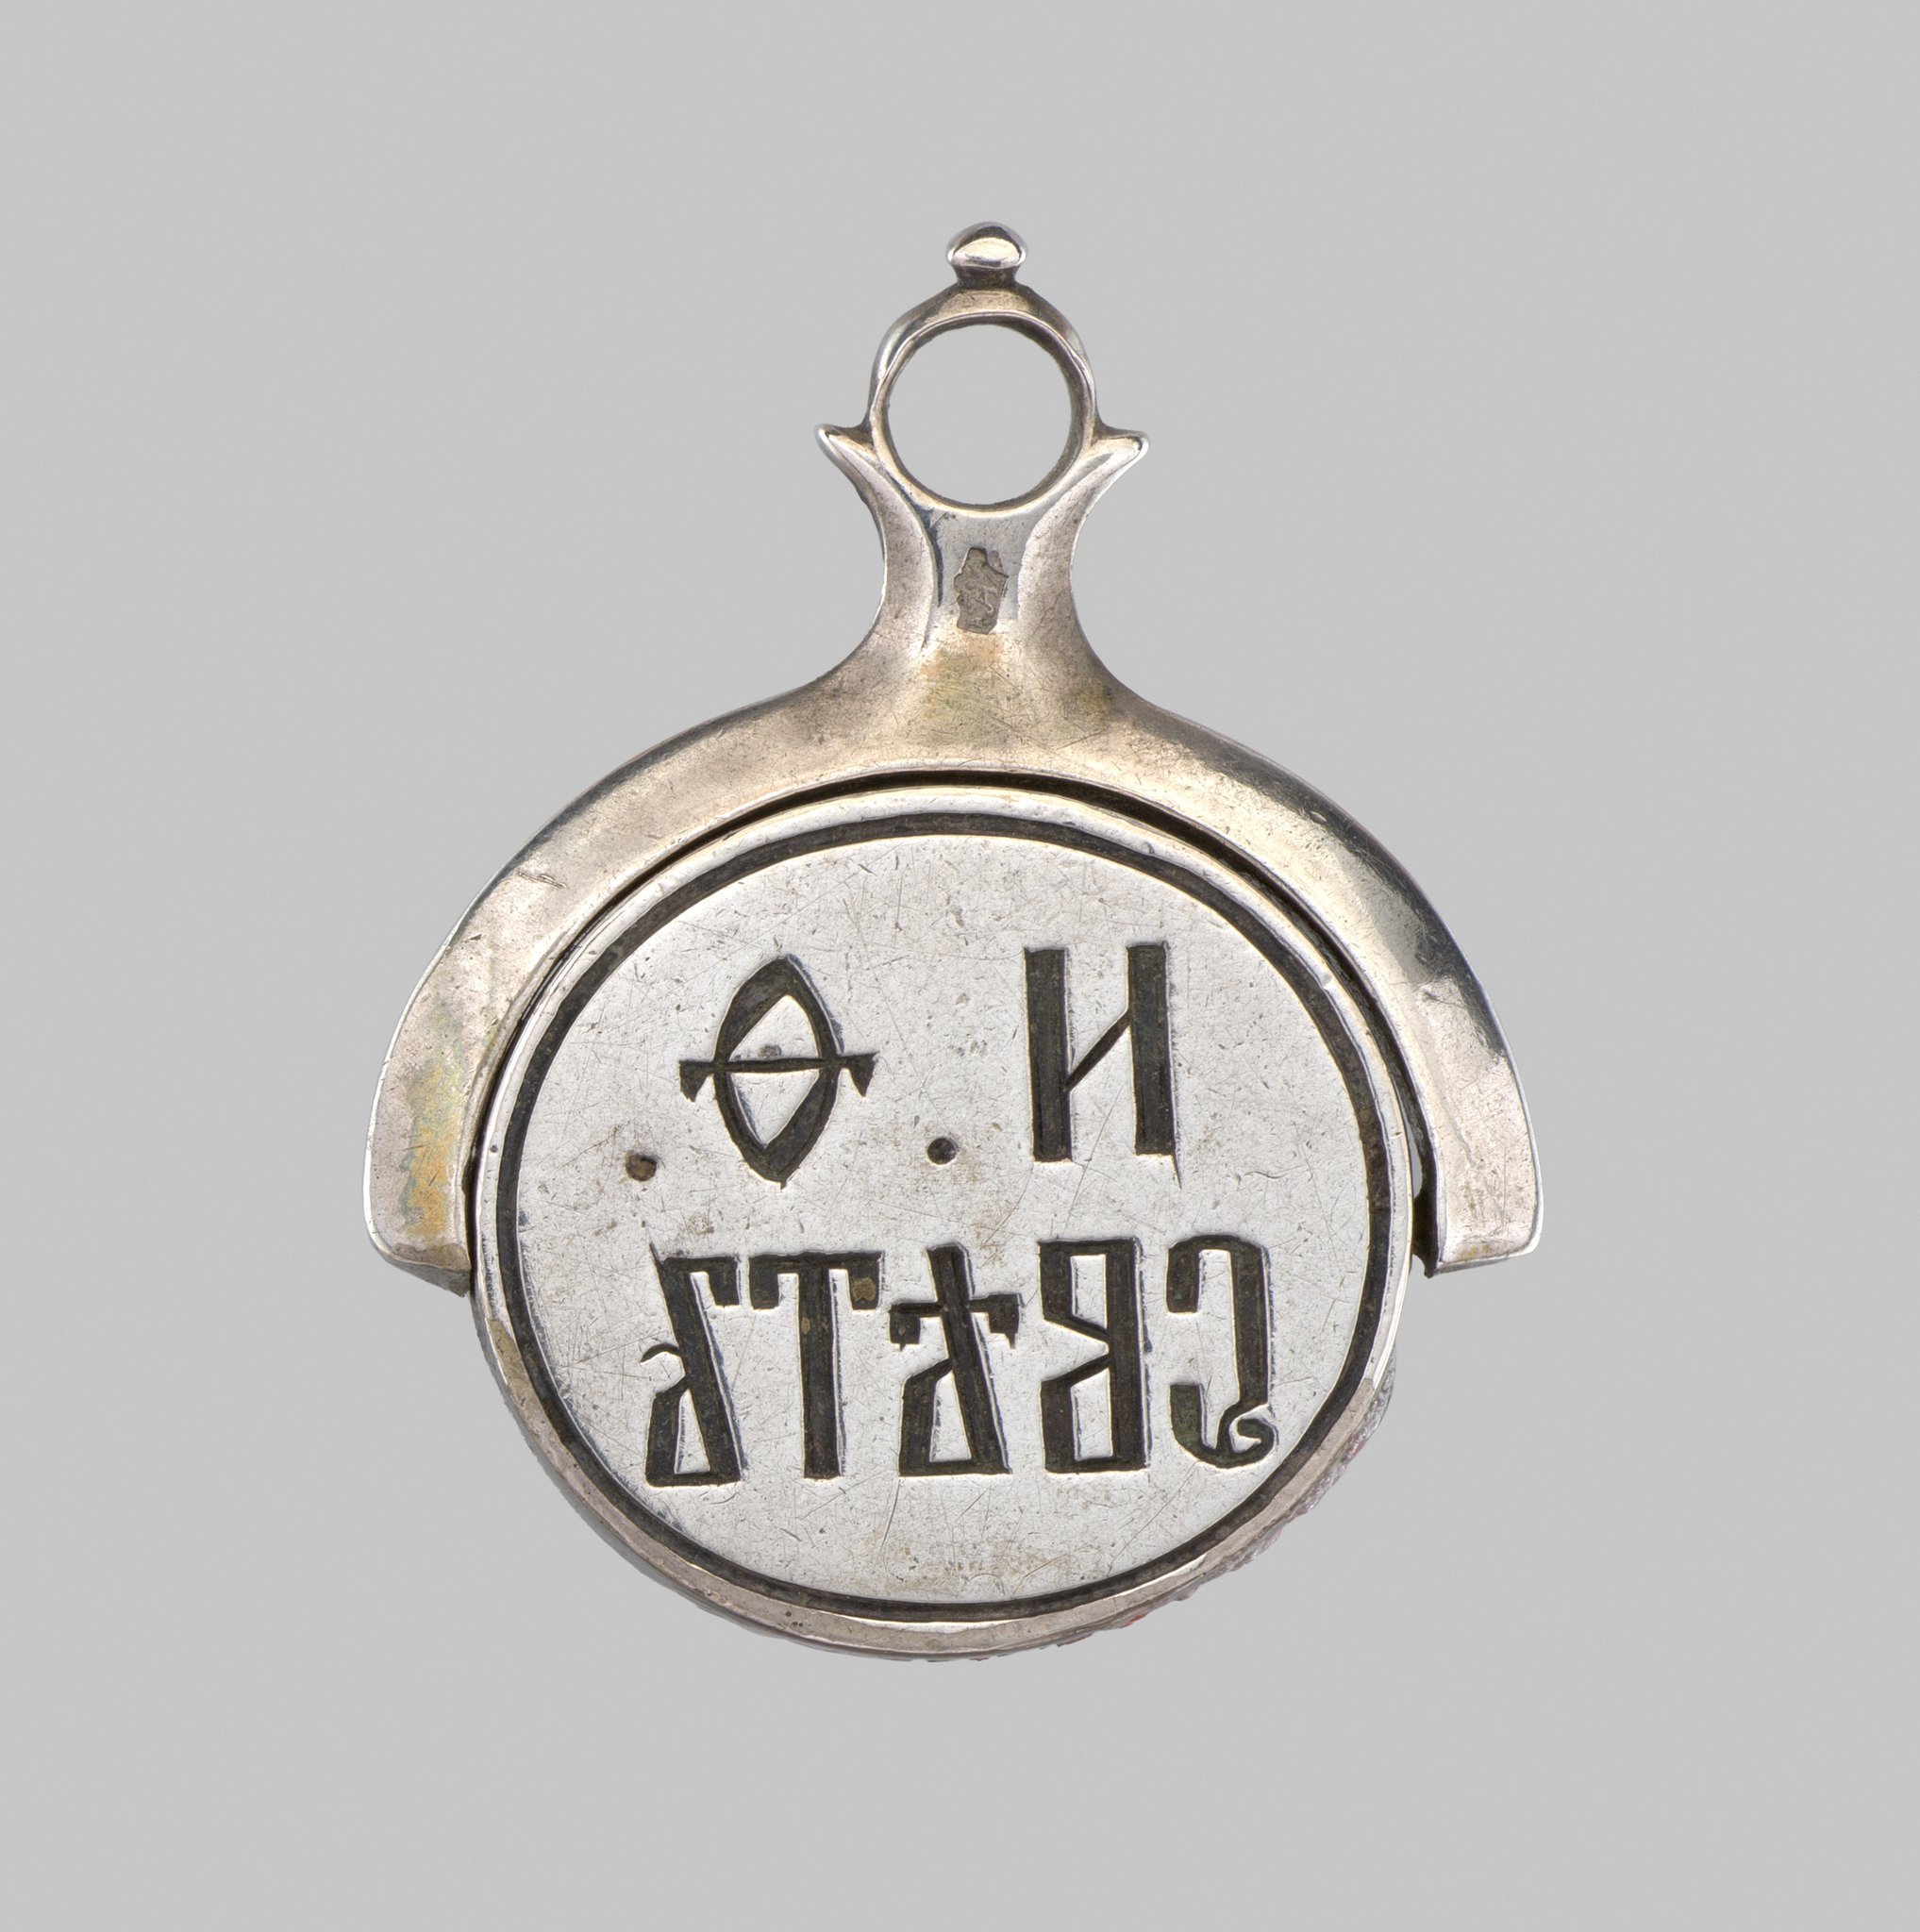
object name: seal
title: Swivel seal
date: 1601-1700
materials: silver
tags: coat of arms